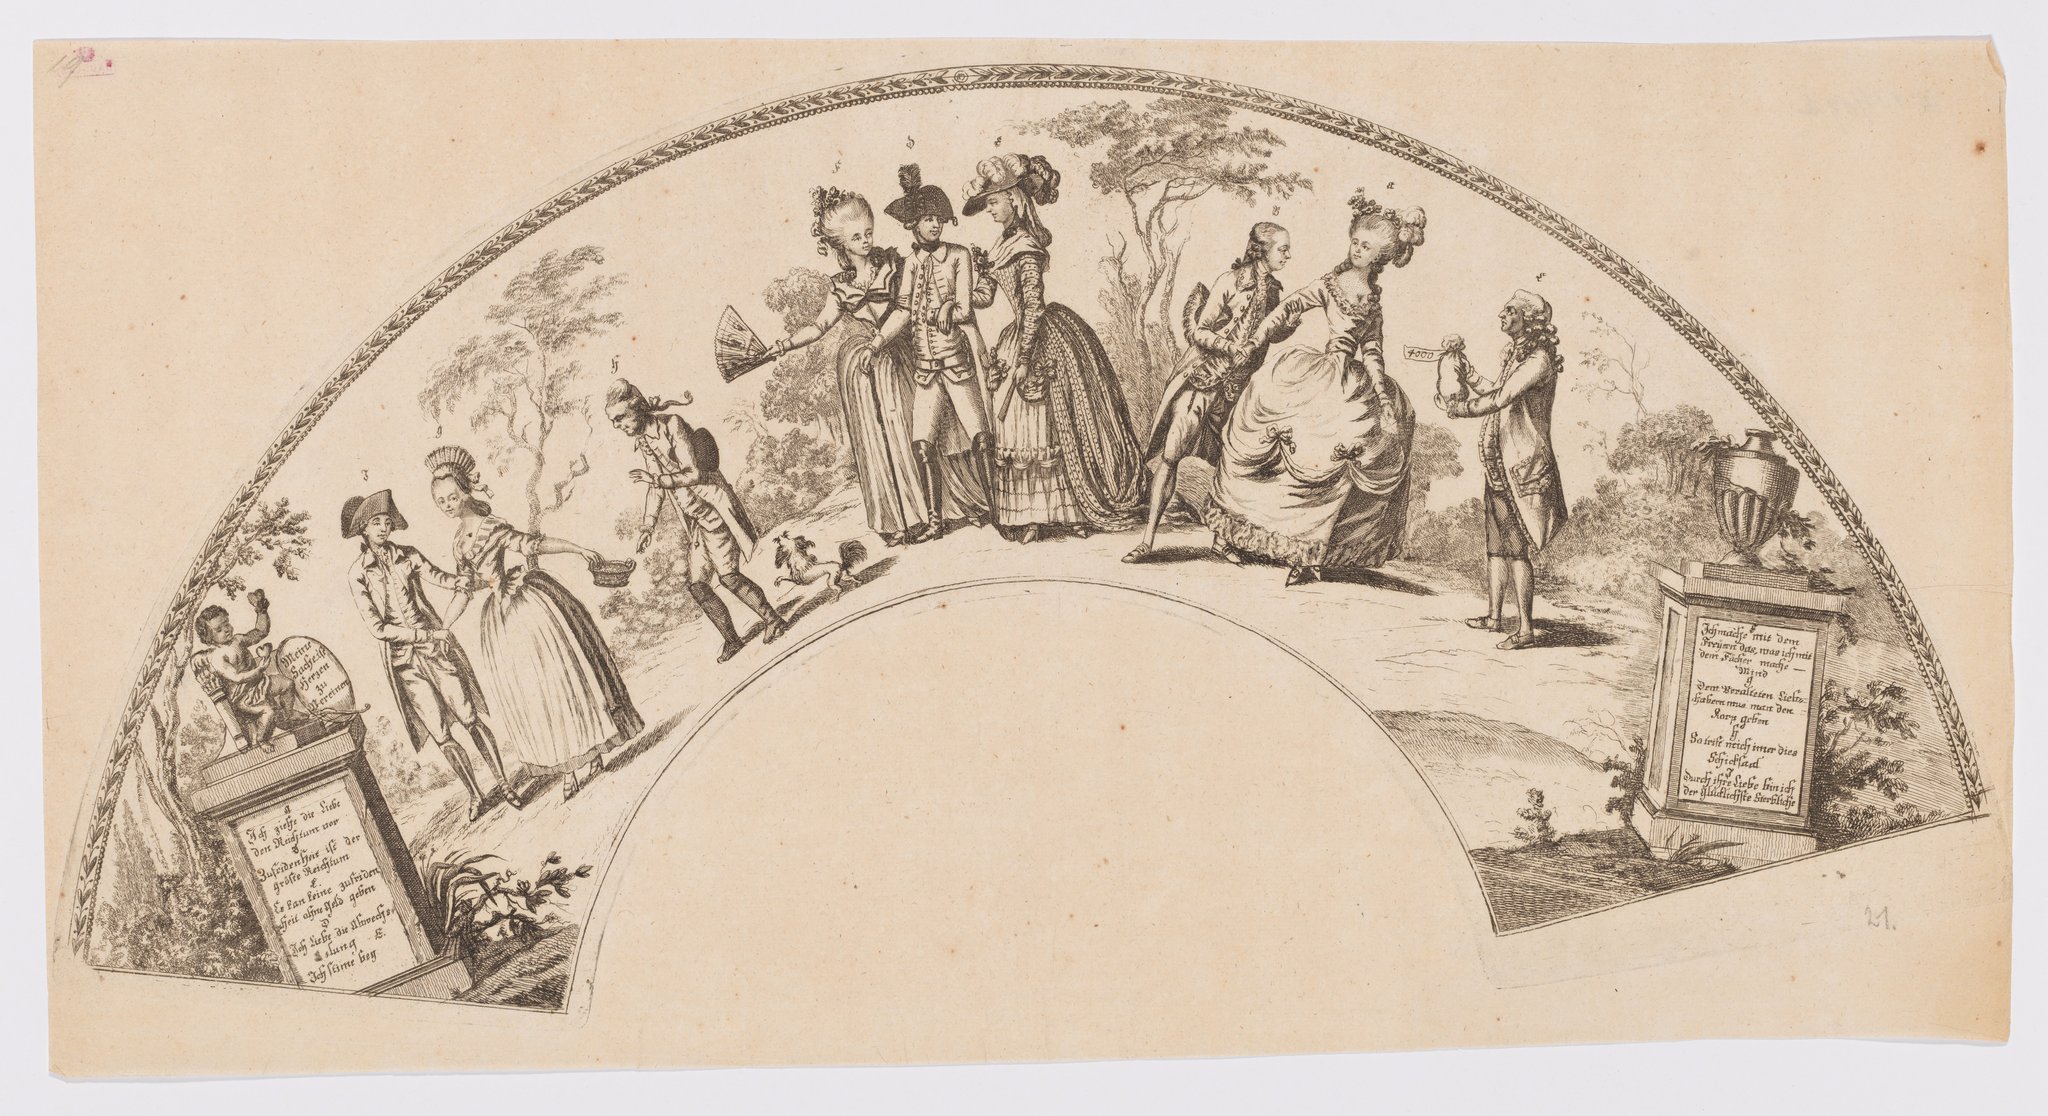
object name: print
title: Design for a fan featuring scenes of courting figures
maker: anonymous, austrian, 18th century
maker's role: artist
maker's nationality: austrian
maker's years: 1700-1800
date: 1701-1800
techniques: etching